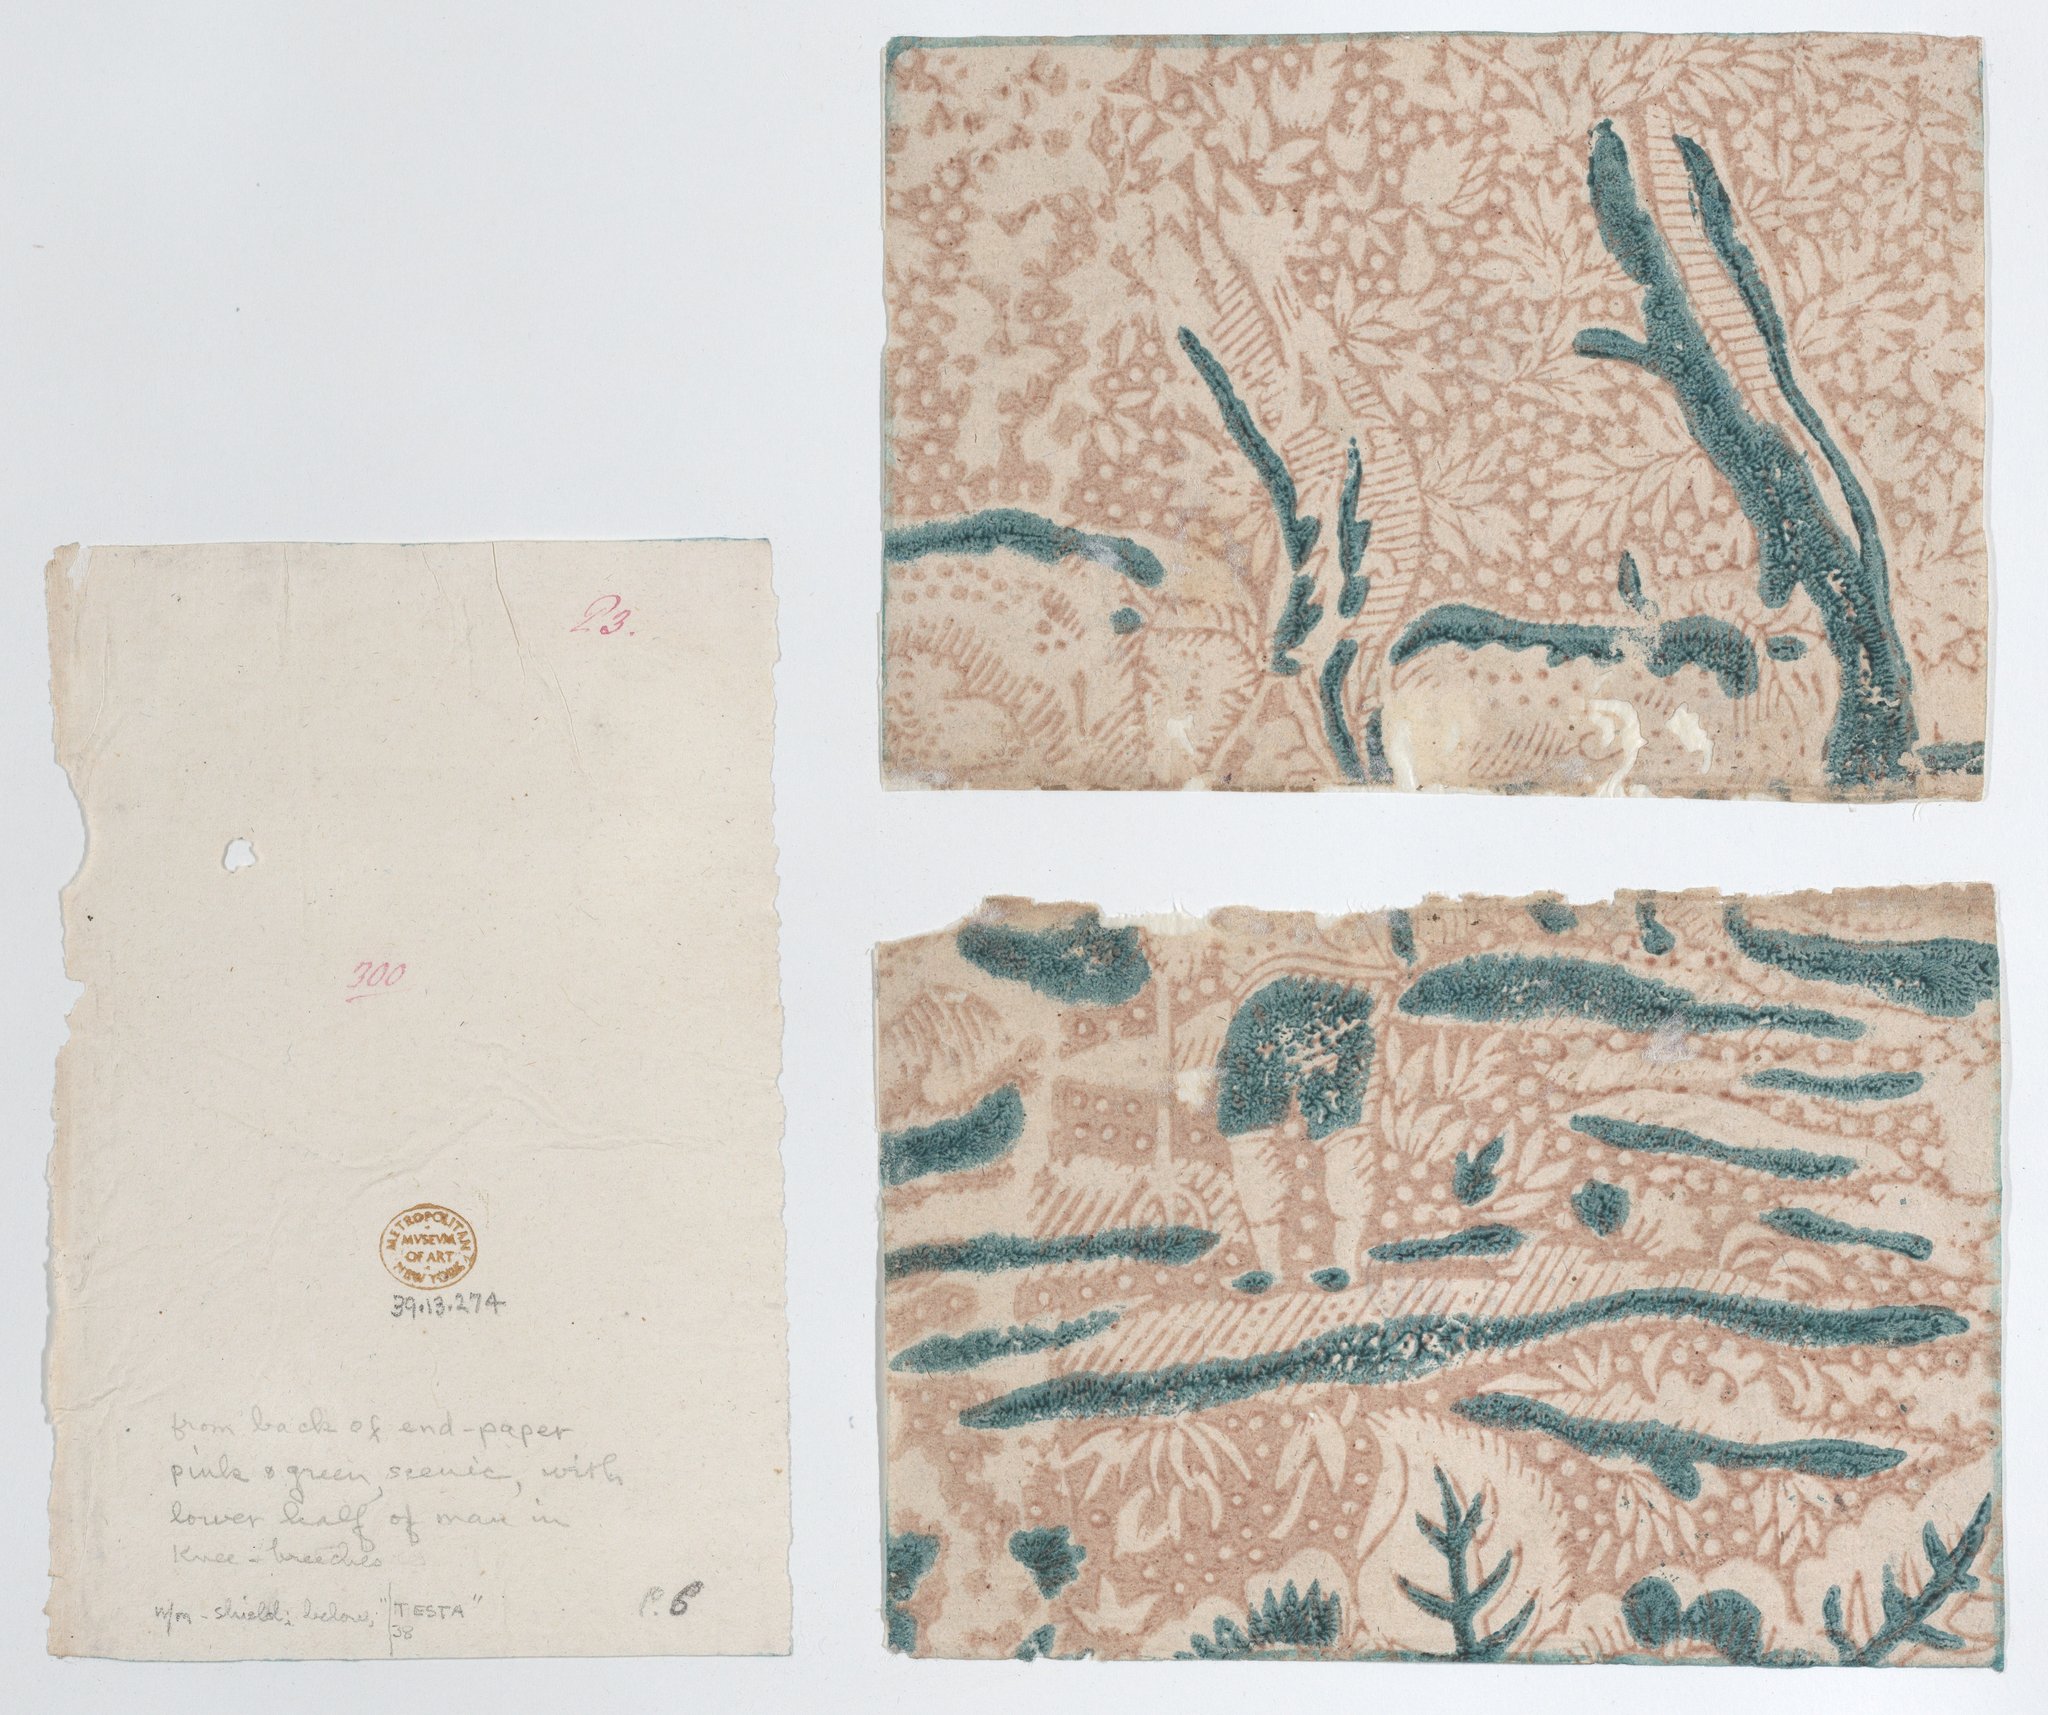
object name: print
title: Sheet in two sections with pink and green scenic pattern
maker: Anonymous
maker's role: artist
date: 1701-1800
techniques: relief print